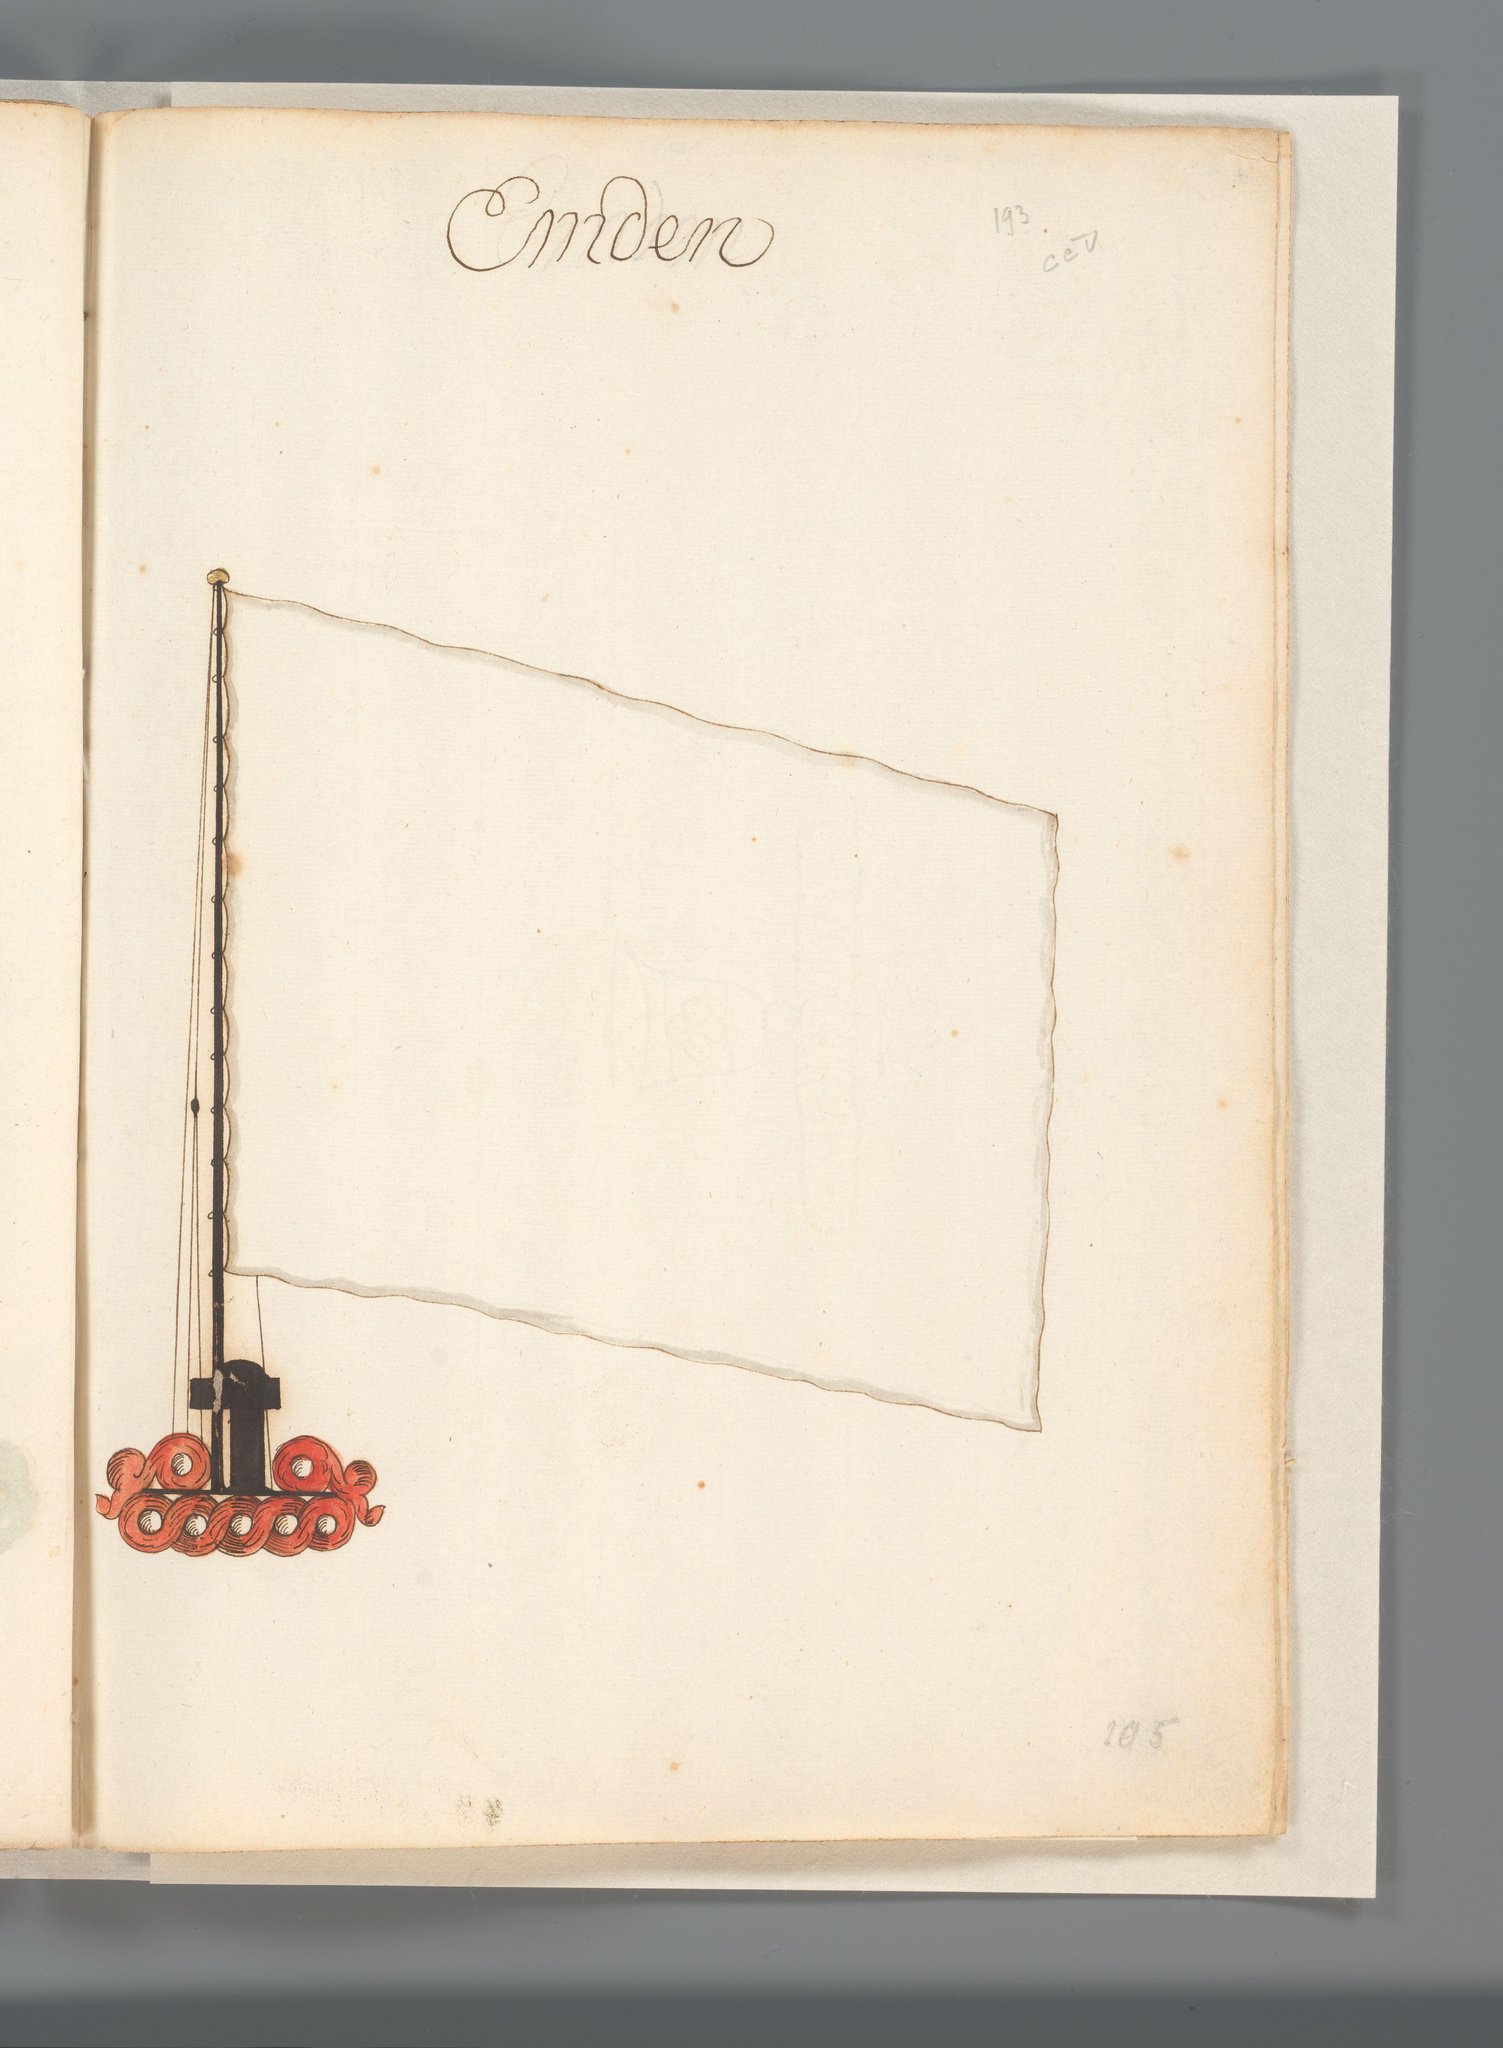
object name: drawing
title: Vlag van Emden (blanco)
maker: Anonymous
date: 1667-1670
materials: ink, paper, watercolor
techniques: brush, pen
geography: france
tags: flag, colours (as symbol of the state, etc.)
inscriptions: number: ‘193 / CCV / 205’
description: Blanco, oningevulde vlag, bestemd voor de vlag van de stad Emden. Vlag op vlaggensteng en mastvoet. Afgebeeld op folio 103r. Onderdeel van een vlaggenboek met vlaggen uit Europa, Noord-Afrika, Nabije en Verre Oosten.